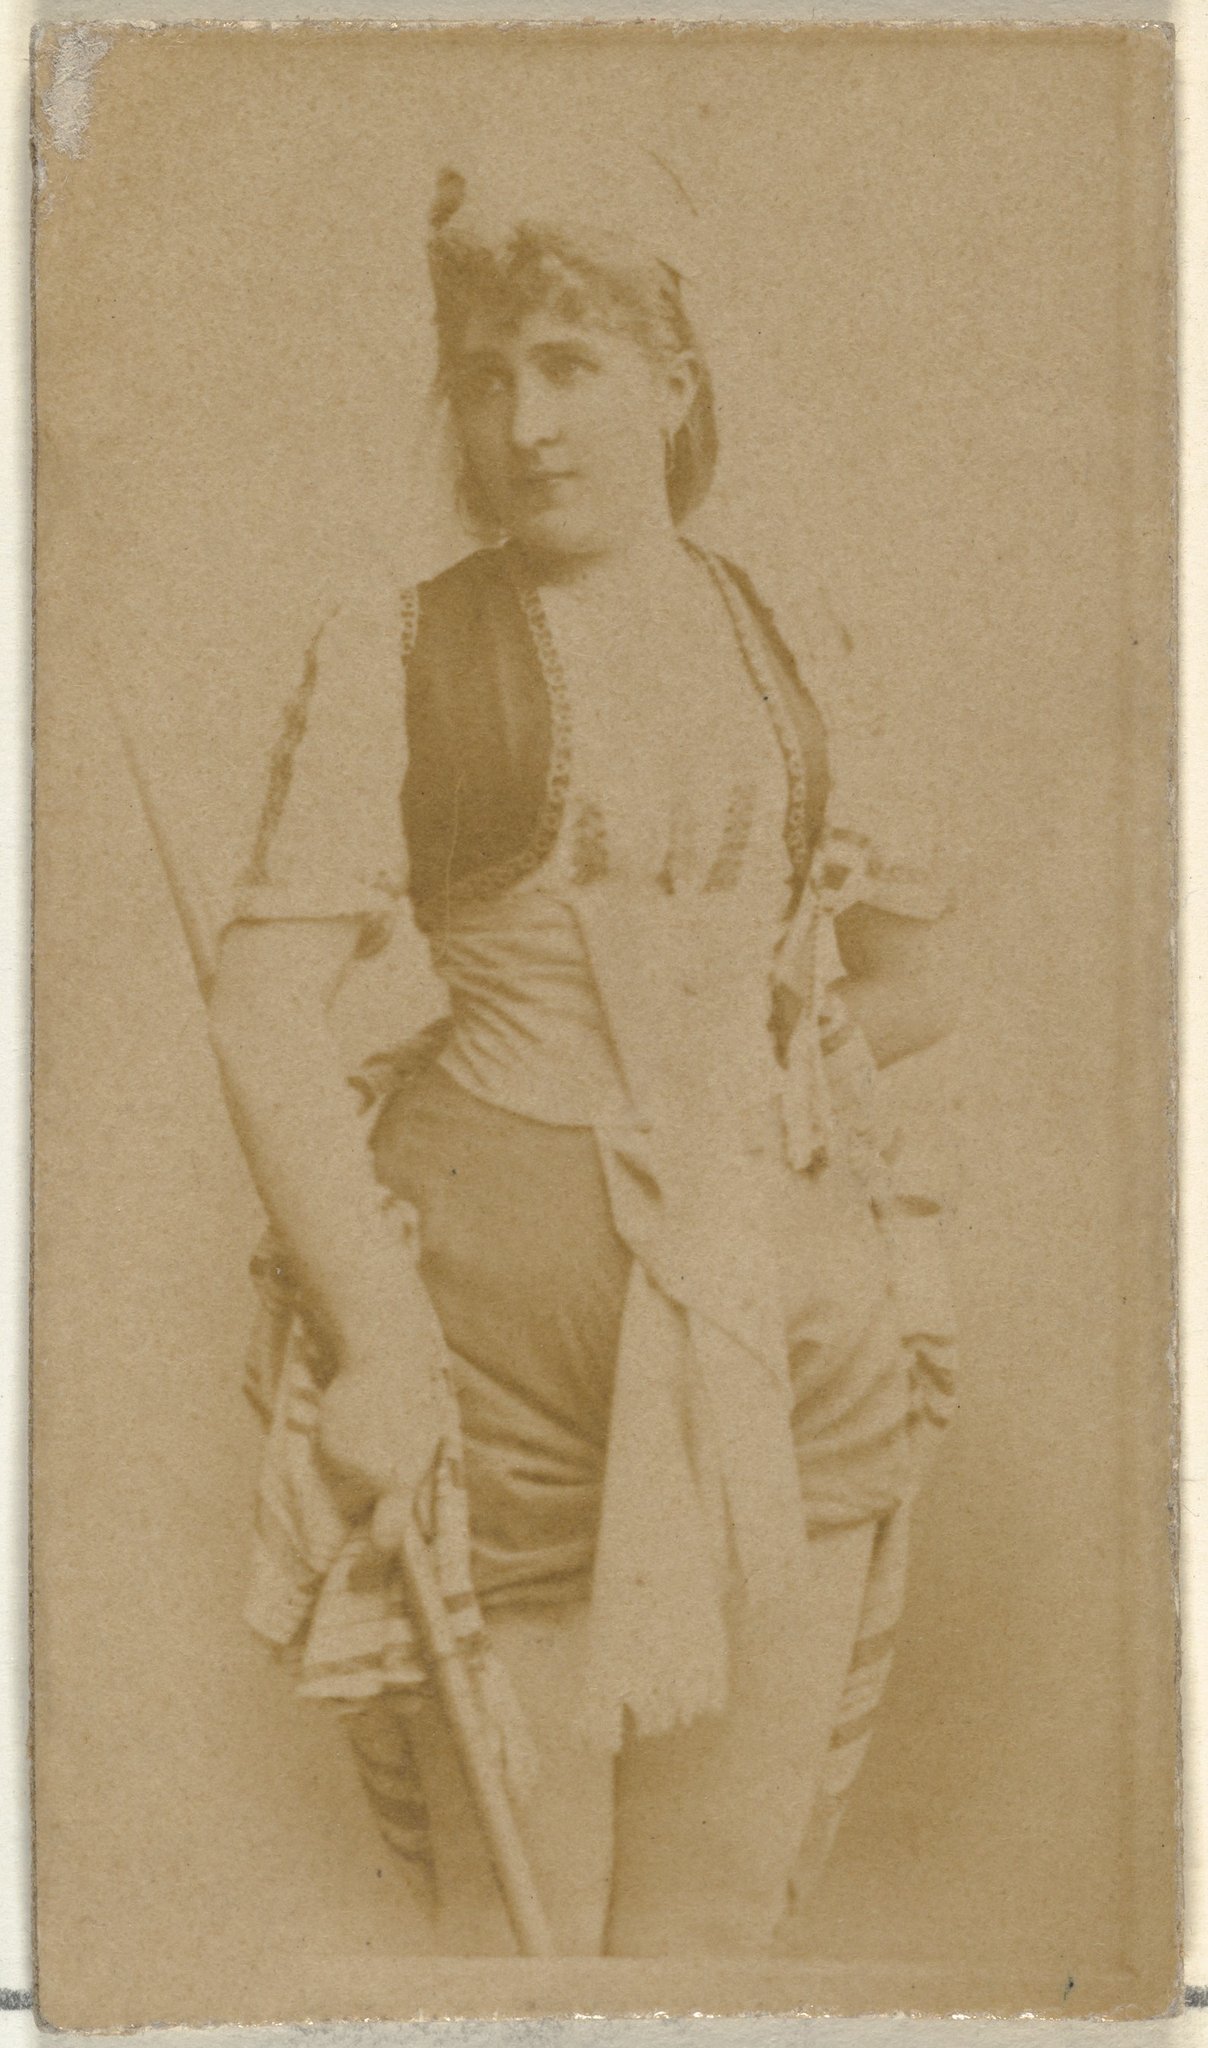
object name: photograph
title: [Actress holding wooden cane], from the Actors and Actresses series (N145-8) issued by Duke Sons & Co. to promote Duke Cigarettes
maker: w. duke, sons & co.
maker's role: publisher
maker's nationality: american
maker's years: 1870-1920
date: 1891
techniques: albumen silver print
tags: portraits,women,actresses